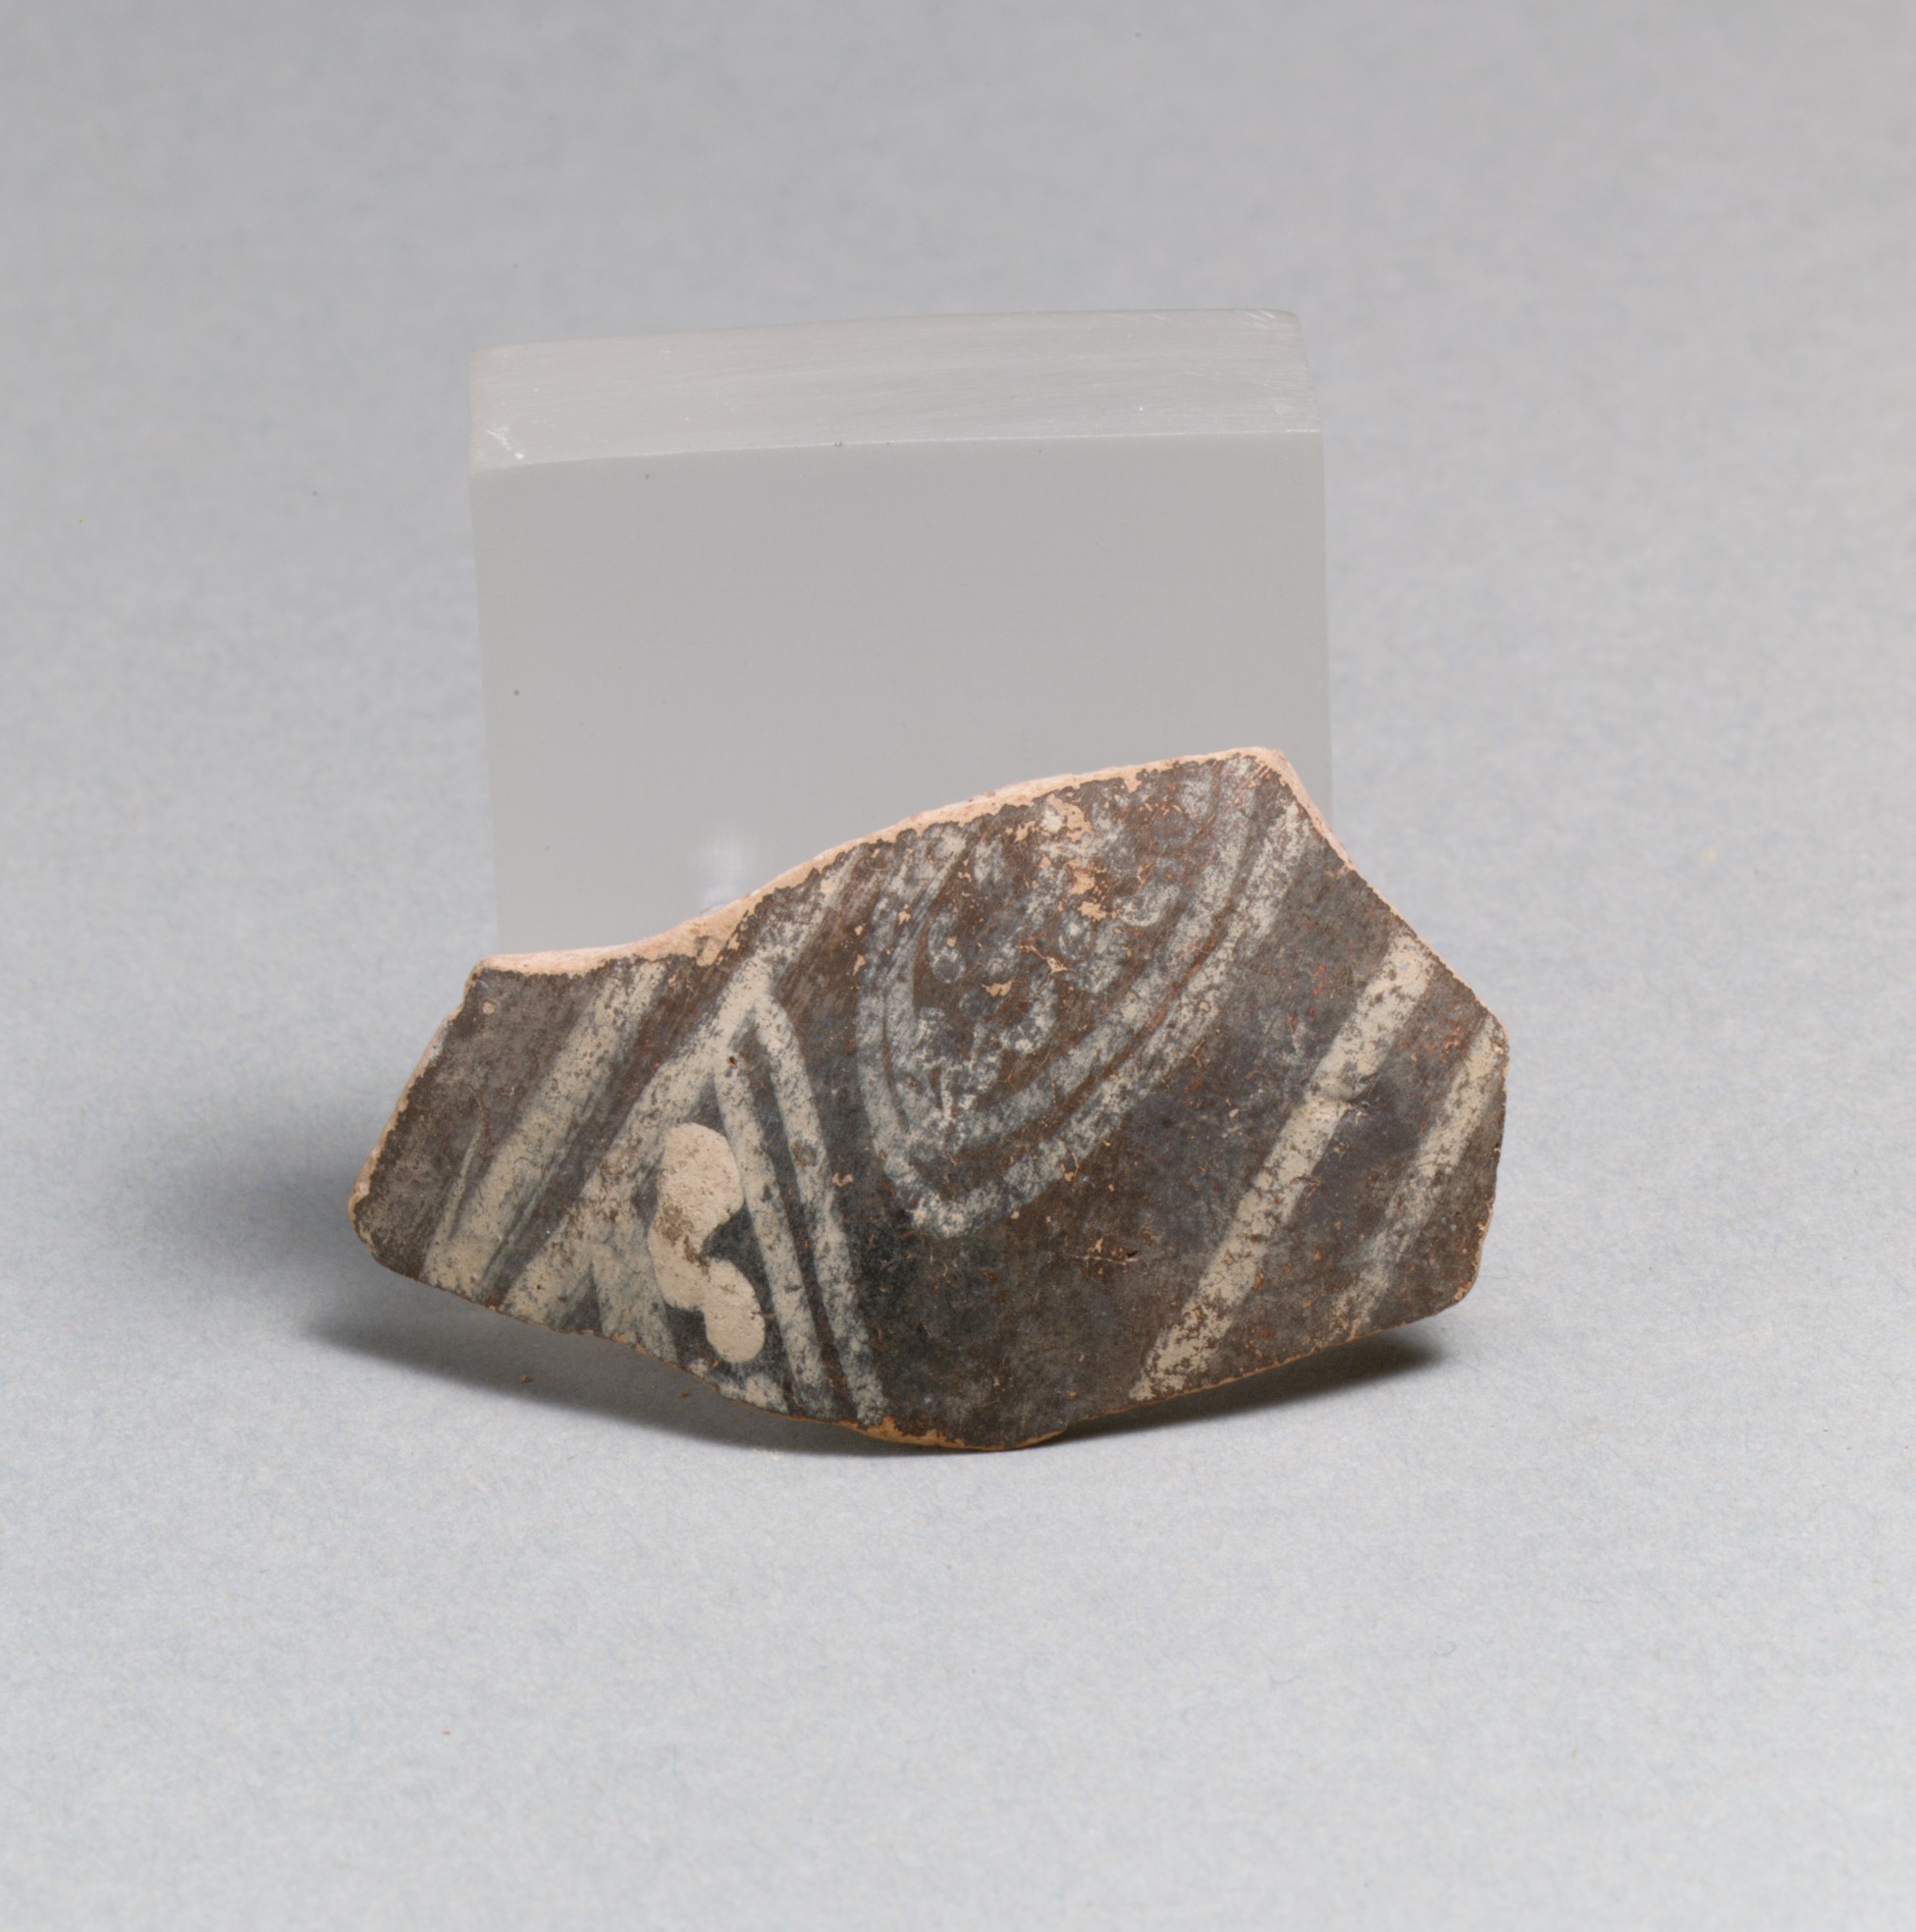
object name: vase fragment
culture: minoan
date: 2600-2000 BCE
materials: terracotta